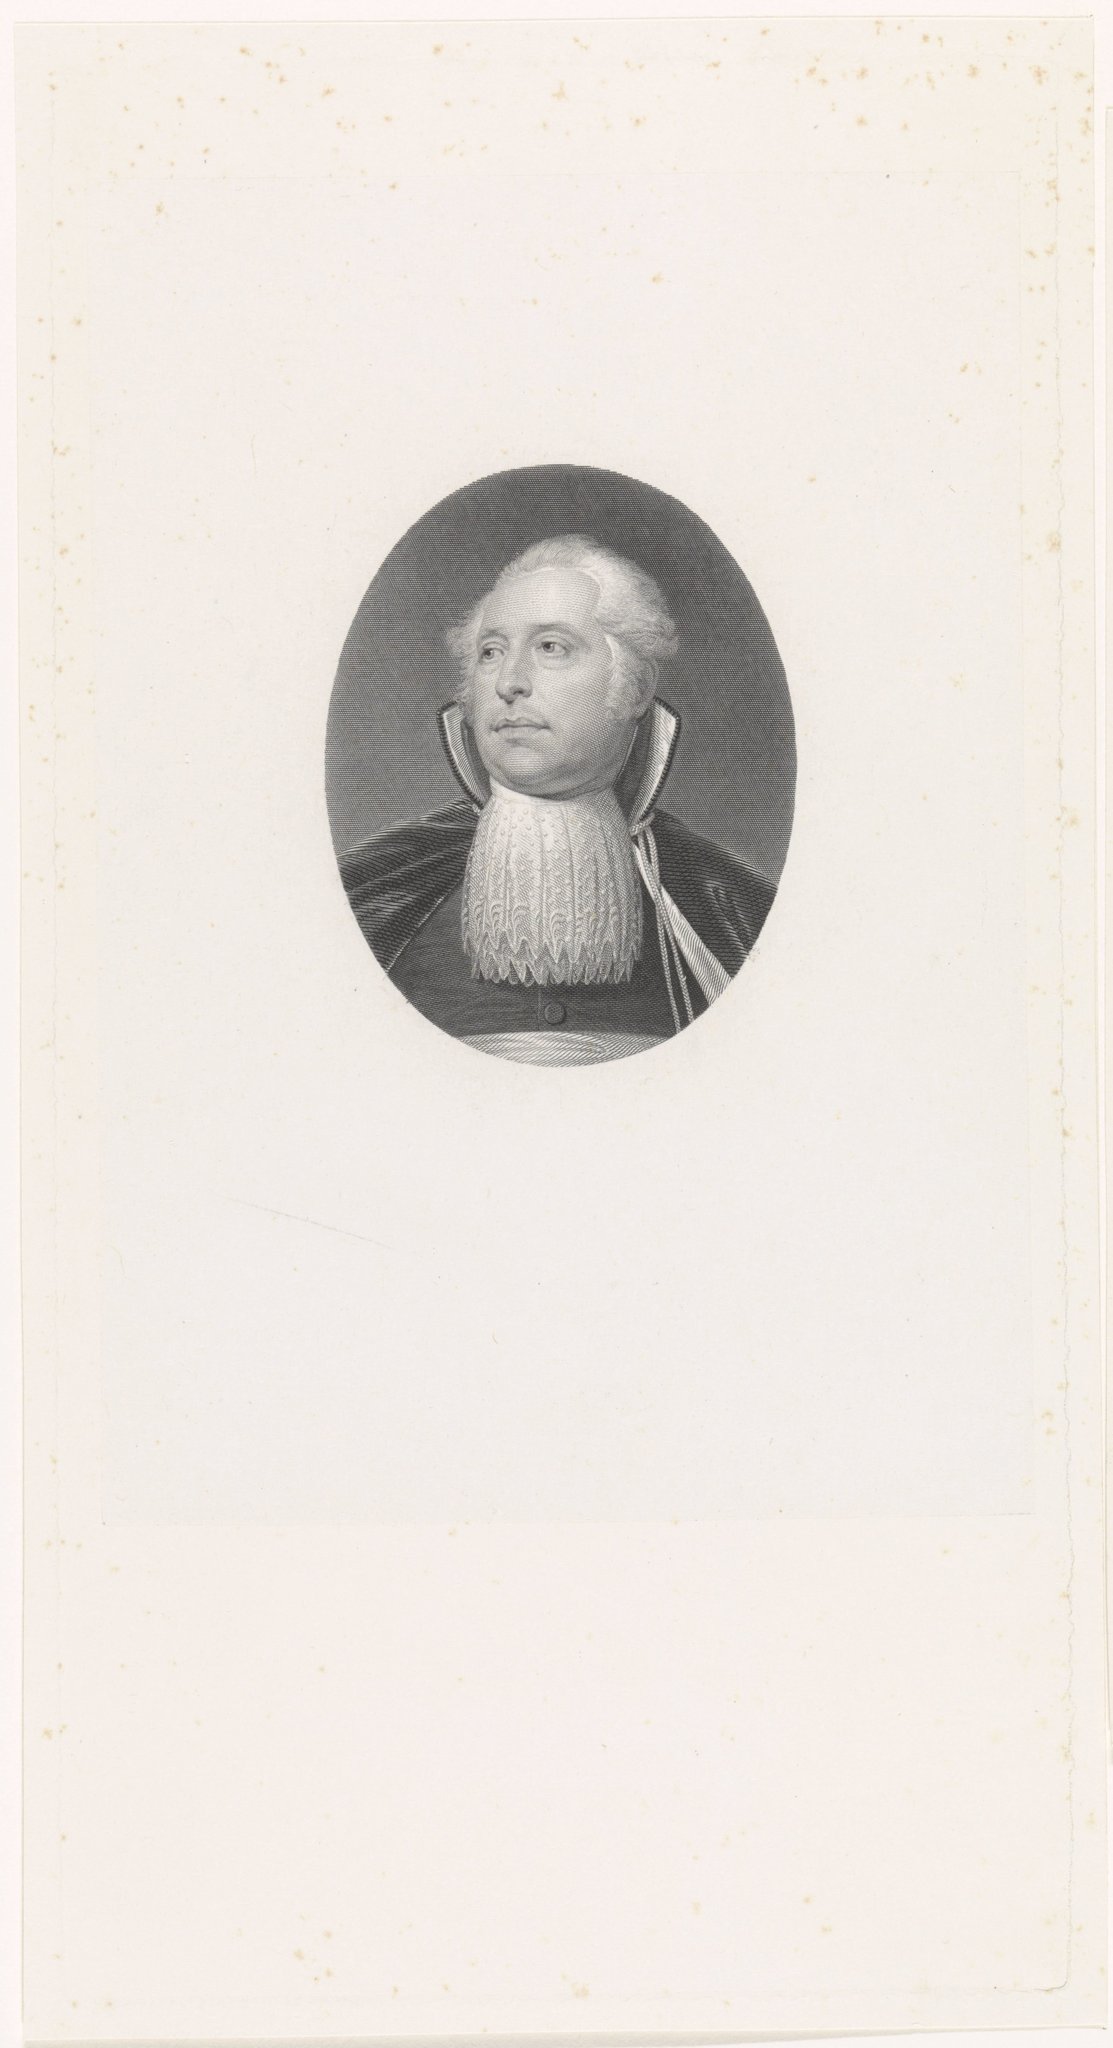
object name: print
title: Portret van Rutger Jan Schimmelpenninck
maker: edouard taurel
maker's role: draughtsman, print maker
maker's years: 1824-1892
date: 1834-1891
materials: paper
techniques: engraving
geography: amsterdam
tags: deventer, amsterdam, rutger jan schimmelpenninck (1761-1825)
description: Portret van de rechtsgeleerde en raadspensionaris van de Bataafse republiek Rutger Jan Schimmelpenninck.